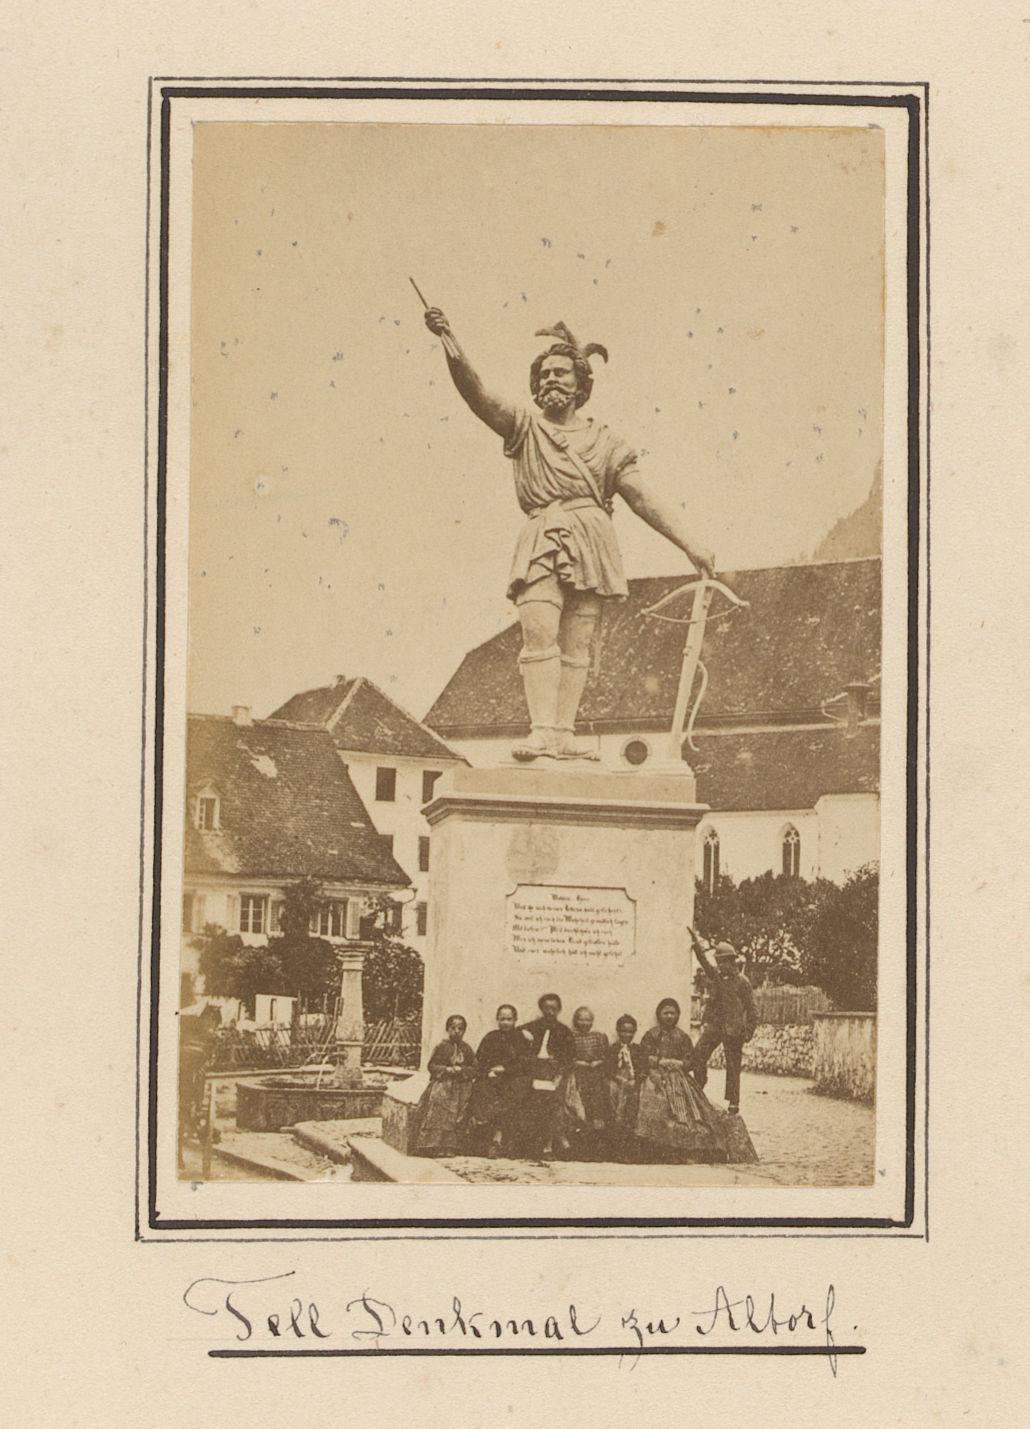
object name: photograph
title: Tell Denkmal zu Altorf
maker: Anonymous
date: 1870-1895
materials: paper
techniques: albumen print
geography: altdorf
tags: monument, statue